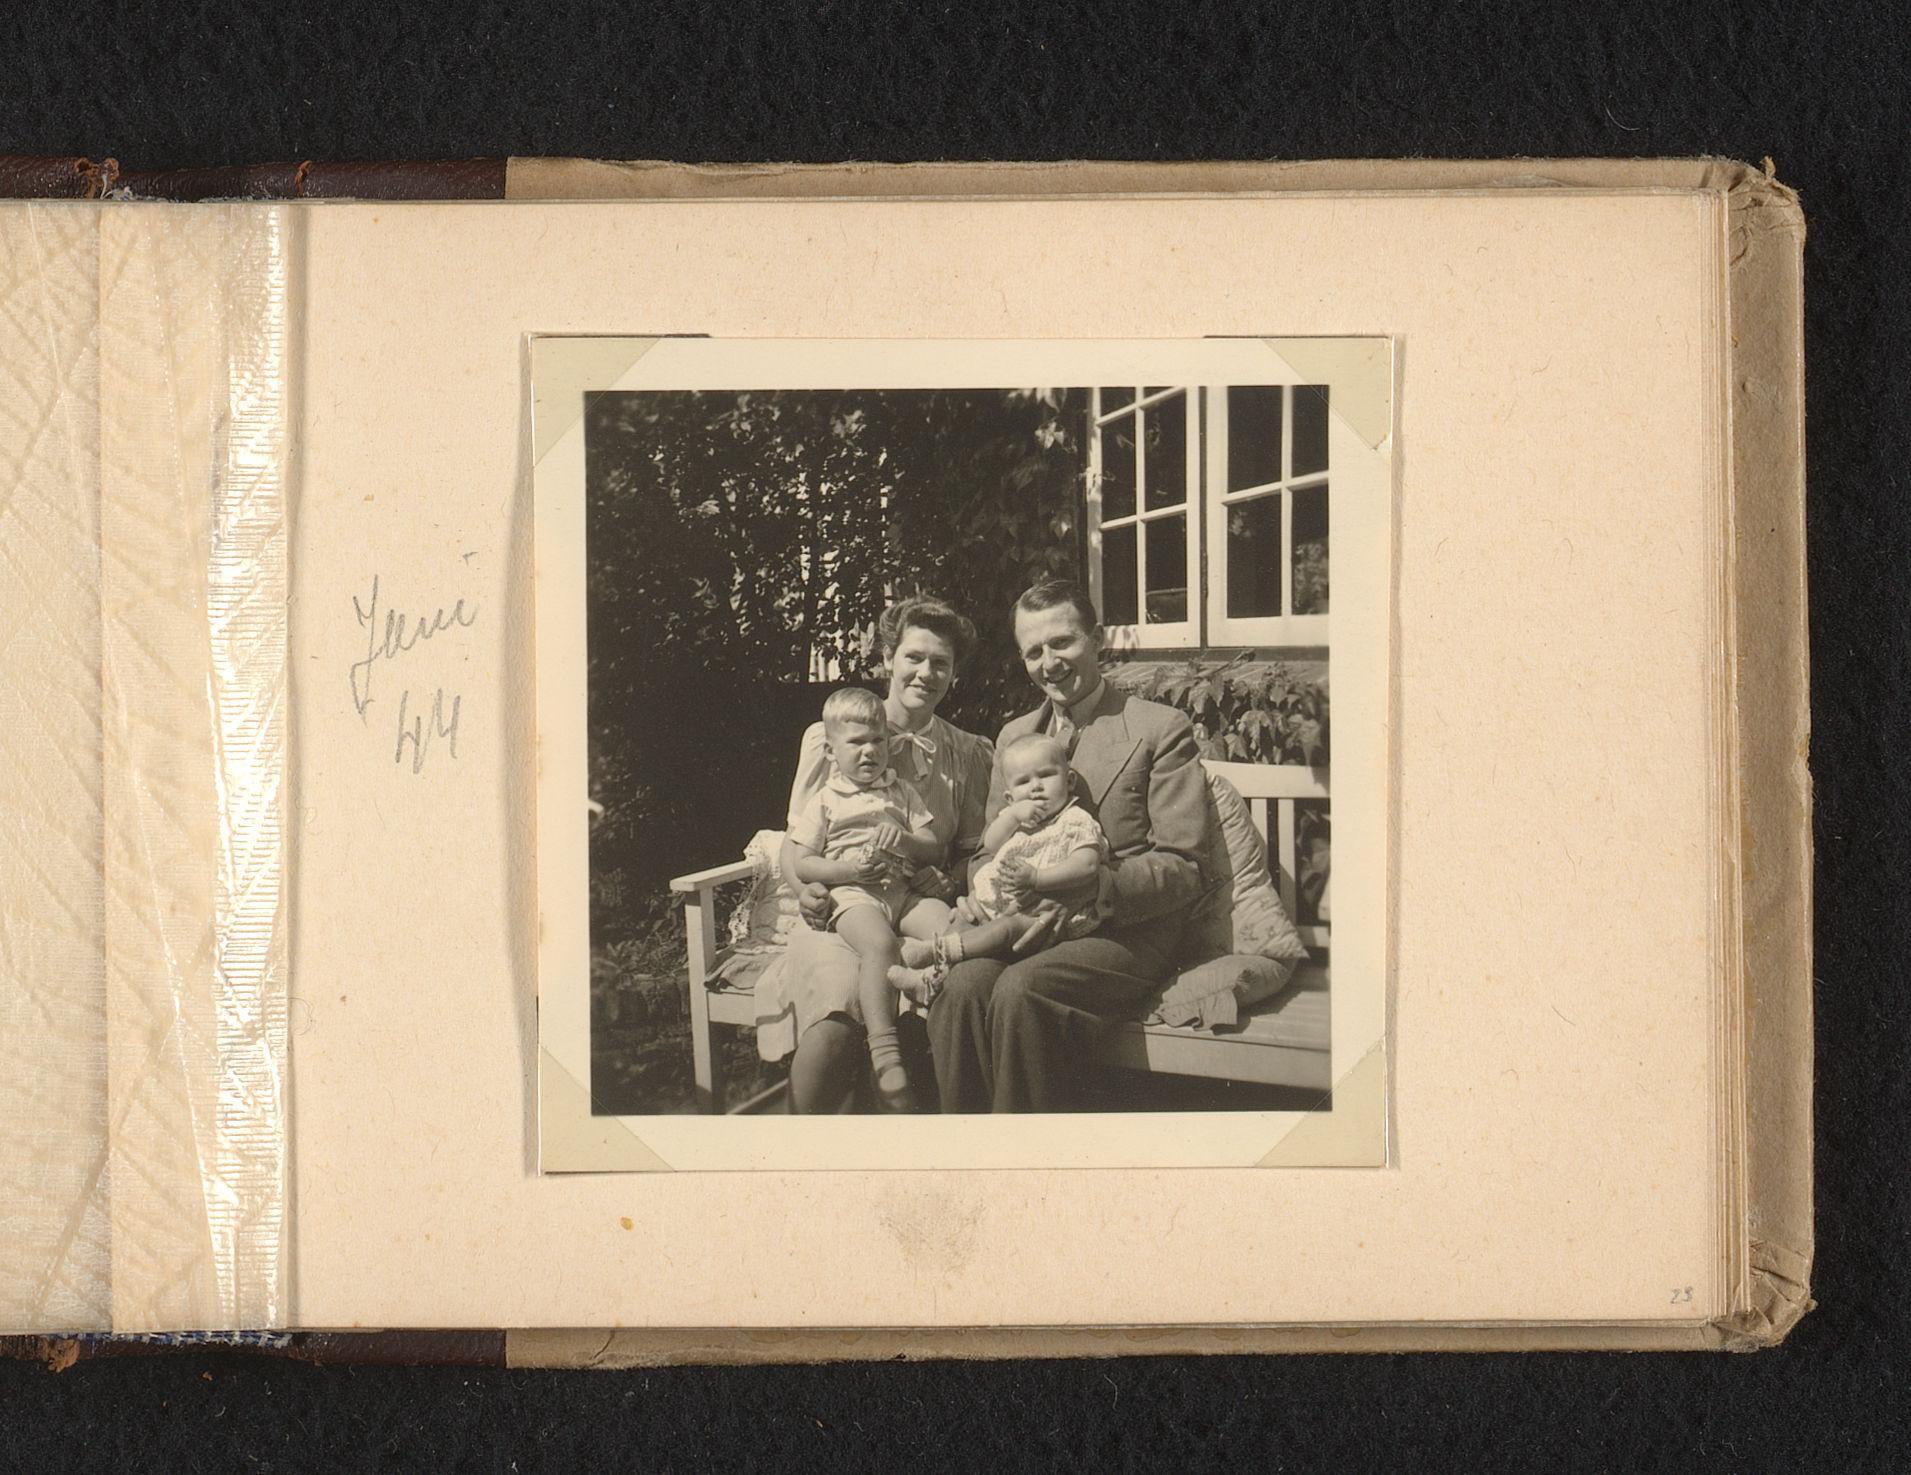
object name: photograph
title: Maria Louise Van den Berg-Halbertsma en Frank Willem van den Berg met hun kinderen Norbert en Louise op een bank in een tuin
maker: norbert peter van den berg (1941-)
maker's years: 1941-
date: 1906-1944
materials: paper, cardboard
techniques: gelatin silver print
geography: netherlands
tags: norbert peter van den berg (1941-), amsterdam, frank willem van den berg (1912-1998), maria louise van den berg-halbertsma, bench, family group, especially parents with their child(ren), garden